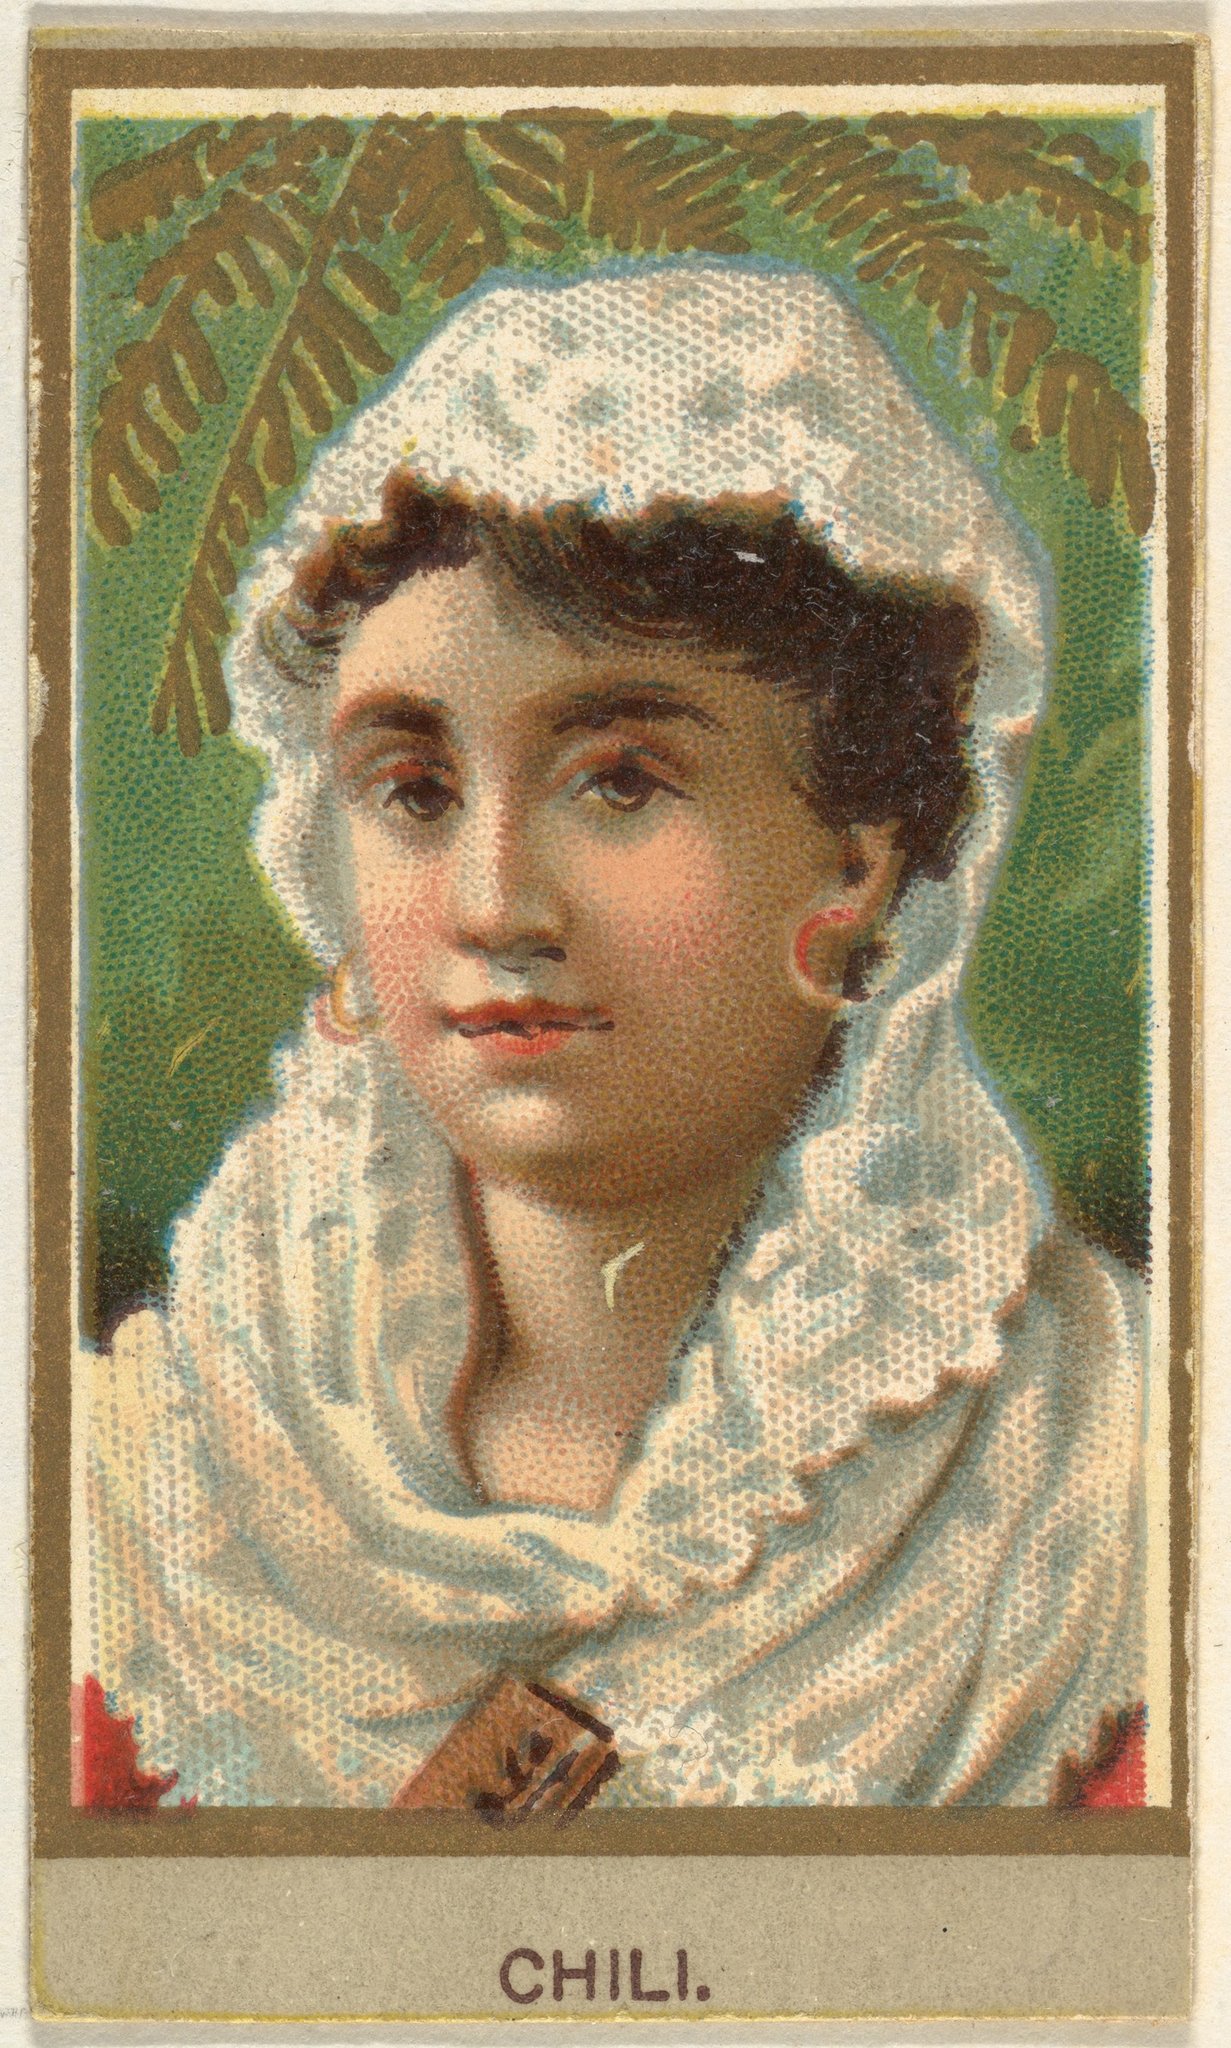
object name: print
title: Chili, from the Races of Mankind series (T181) issued by Abdul Cigarettes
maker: abdul cigarettes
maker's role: publisher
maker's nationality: american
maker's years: 1881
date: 1881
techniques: color lithograph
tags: women